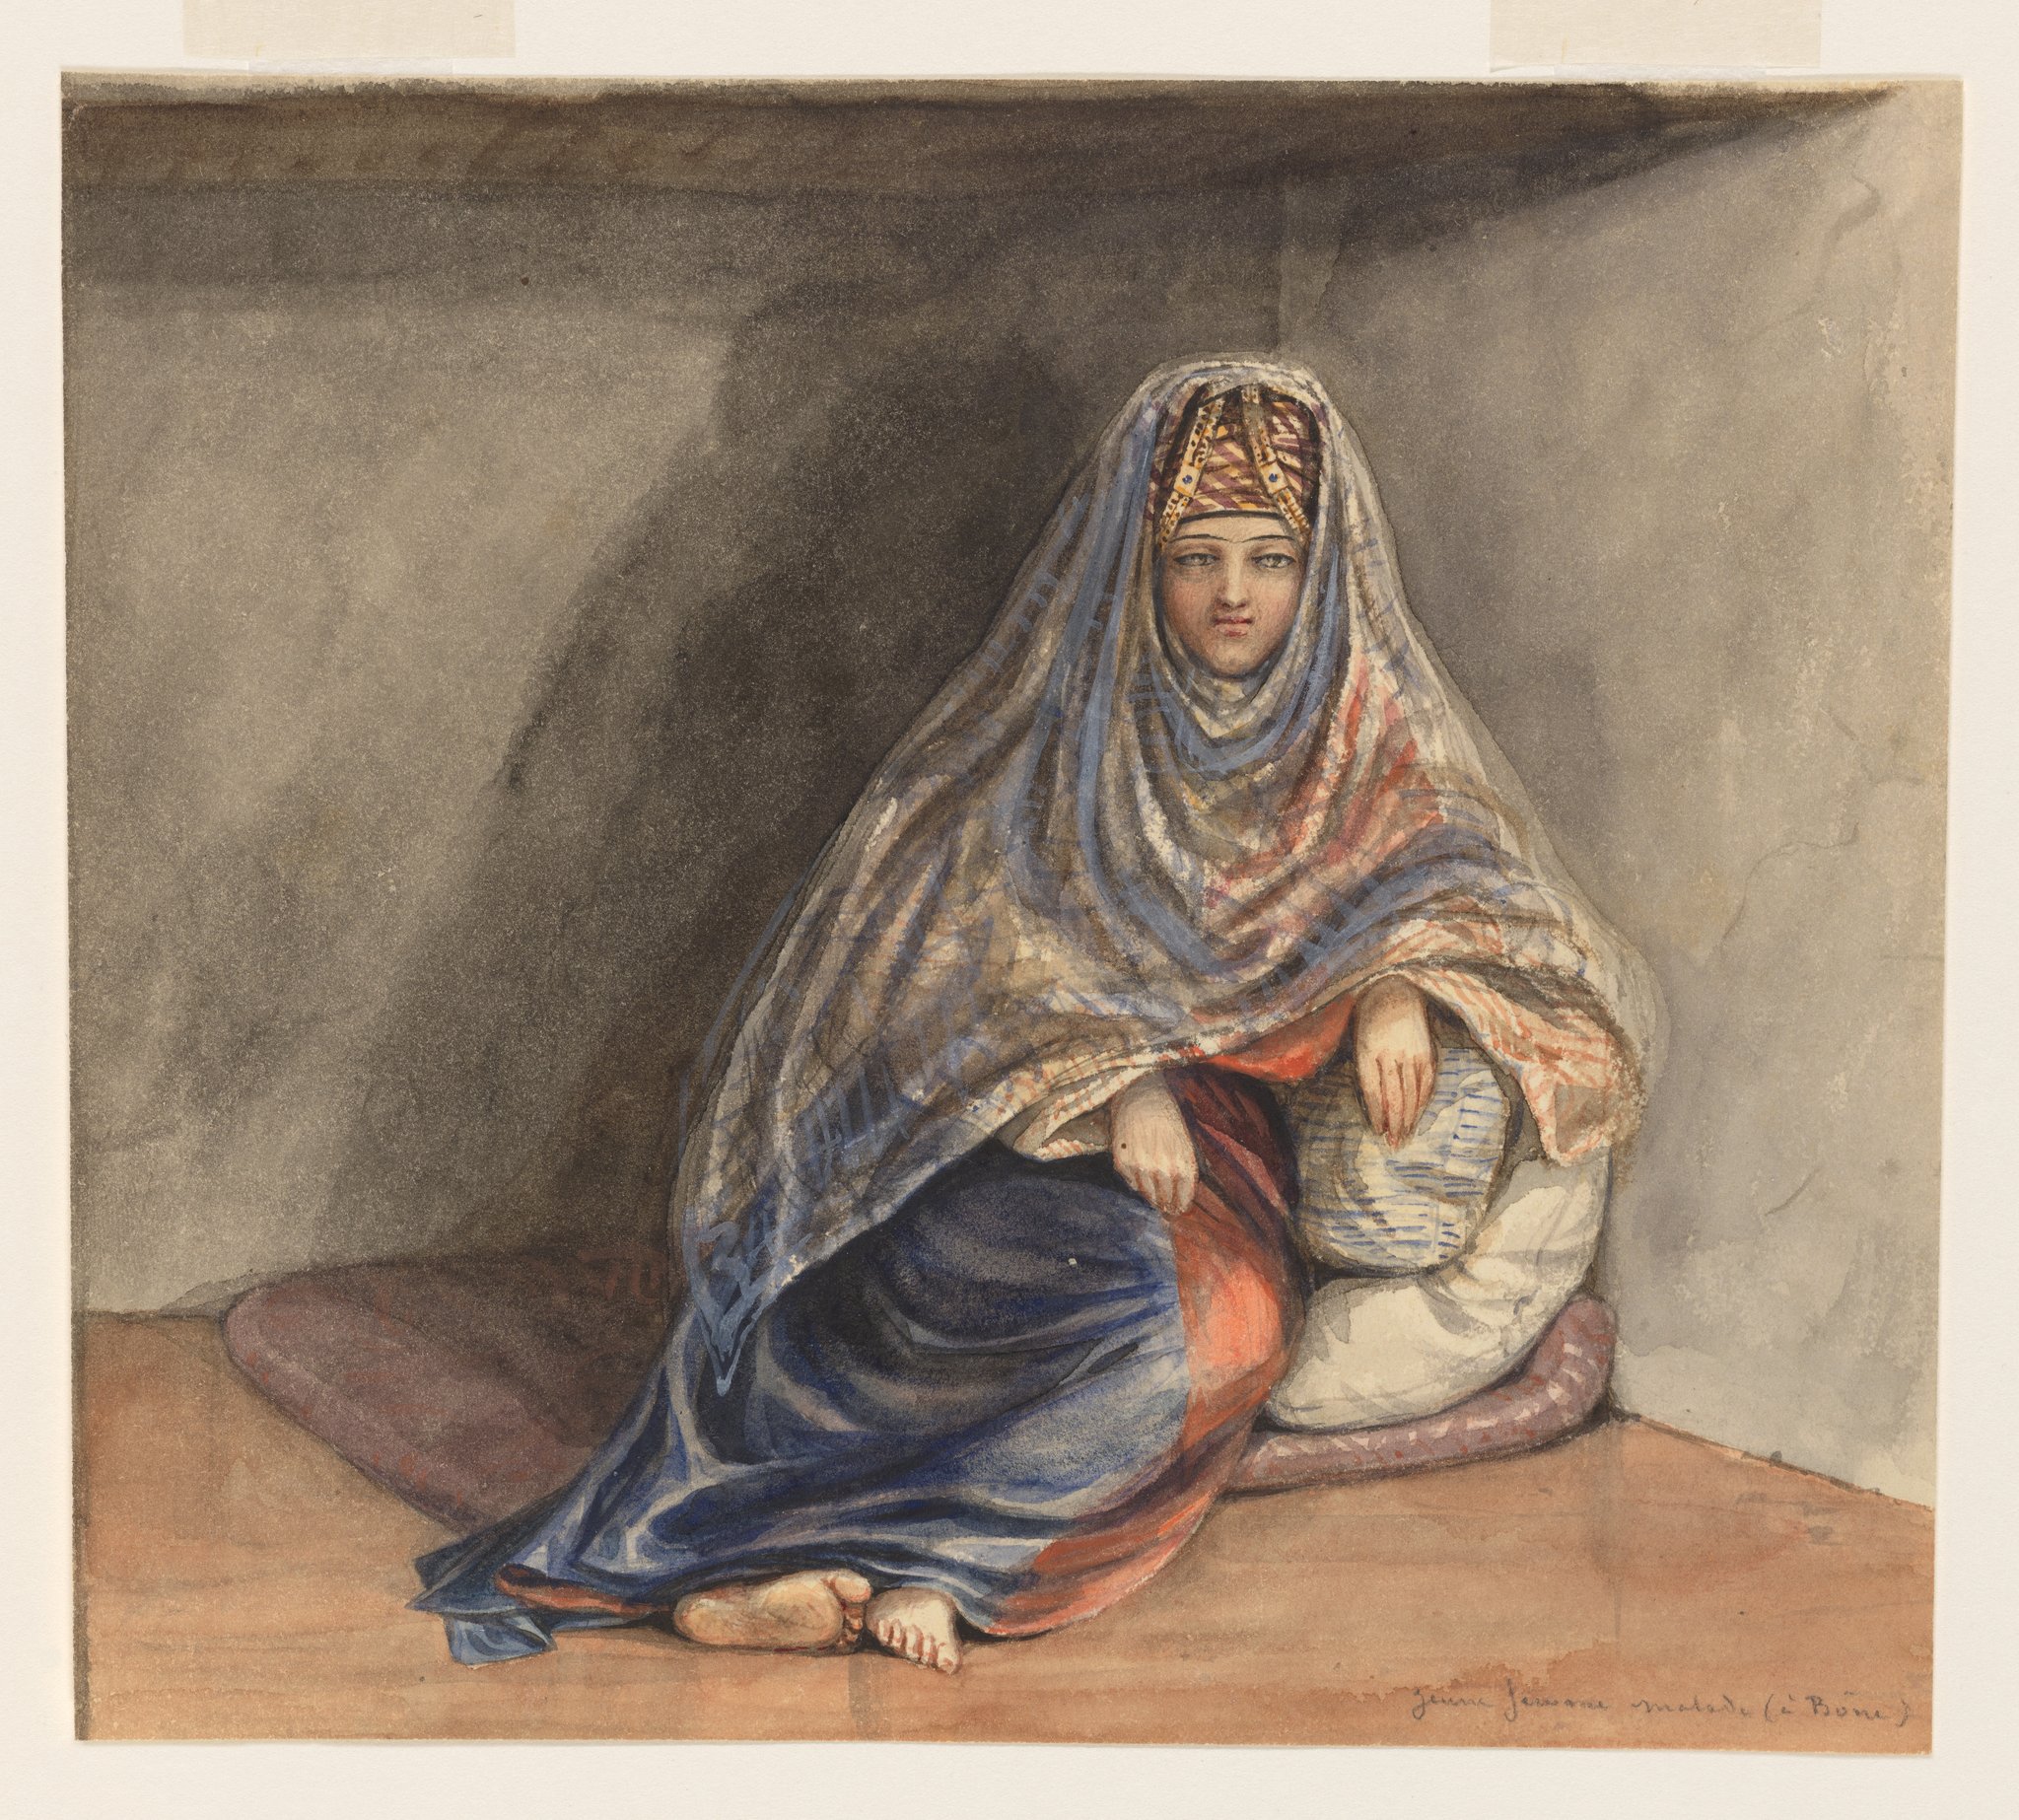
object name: drawing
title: Young Woman from Bône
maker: olivier bro de comères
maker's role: artist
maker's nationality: french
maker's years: 1813-1870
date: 1837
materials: graphite, ink, watercolor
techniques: pen